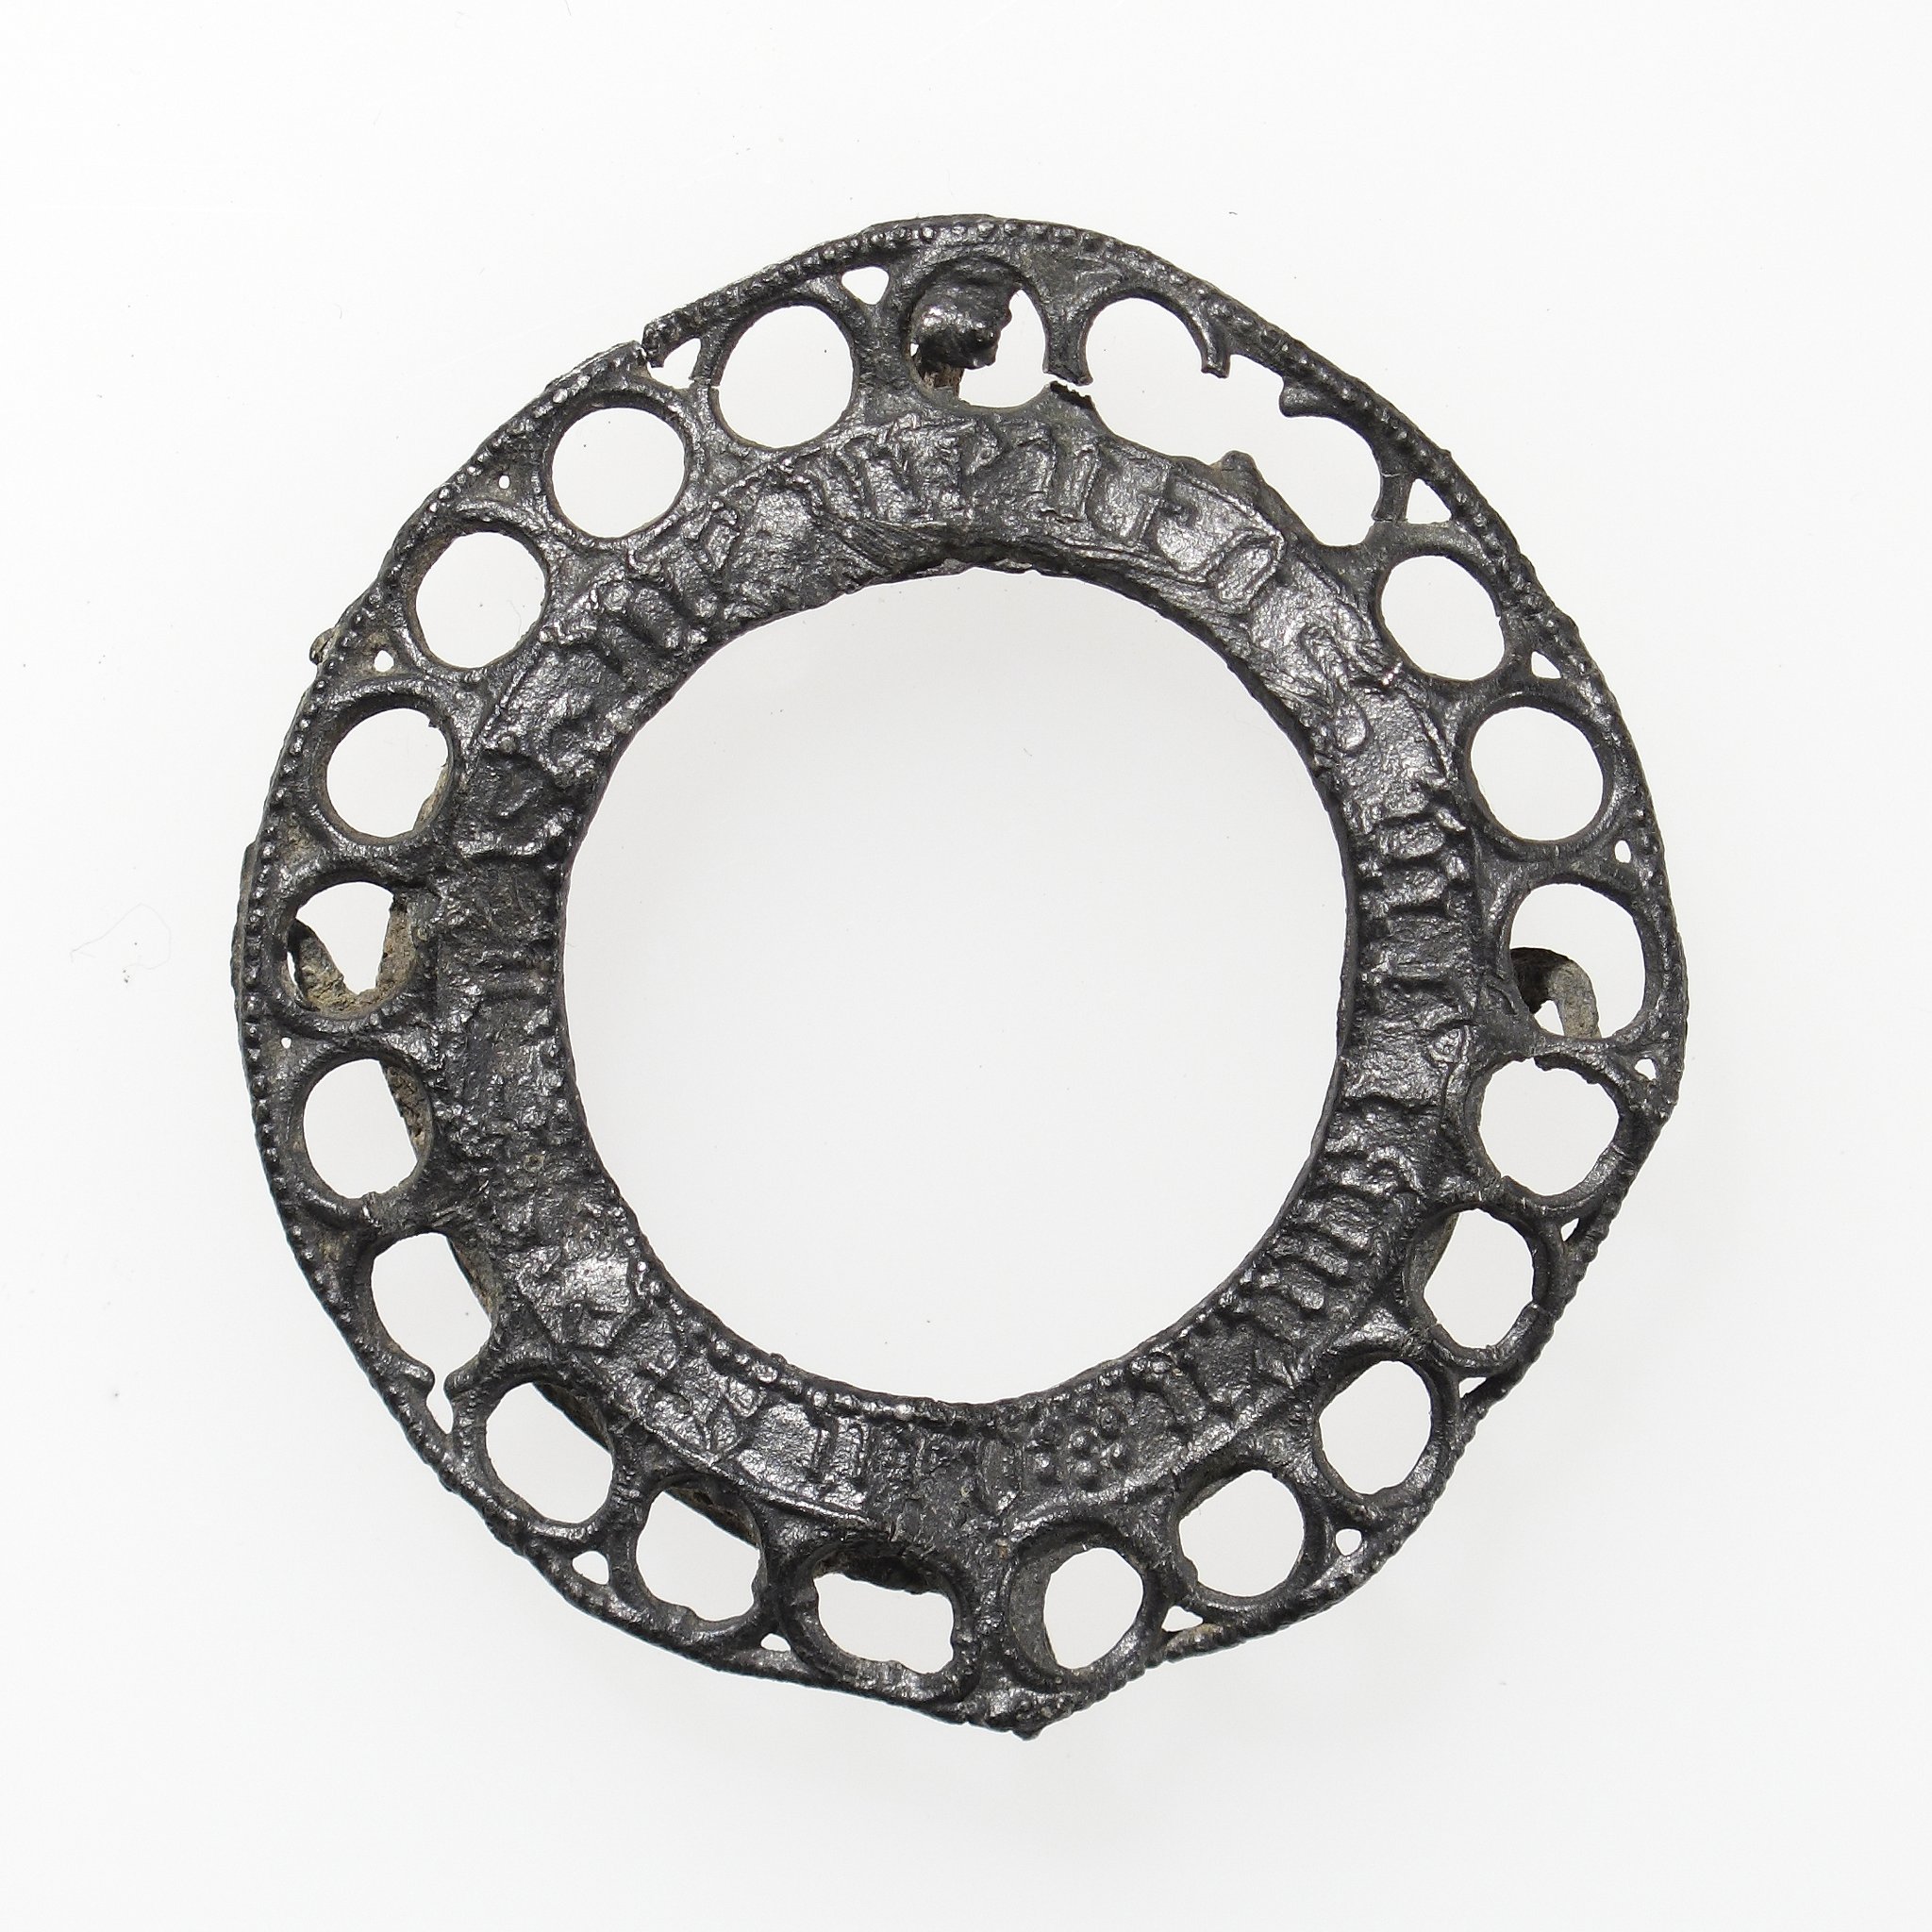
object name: pilgrim's badge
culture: french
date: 1301-1600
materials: lead